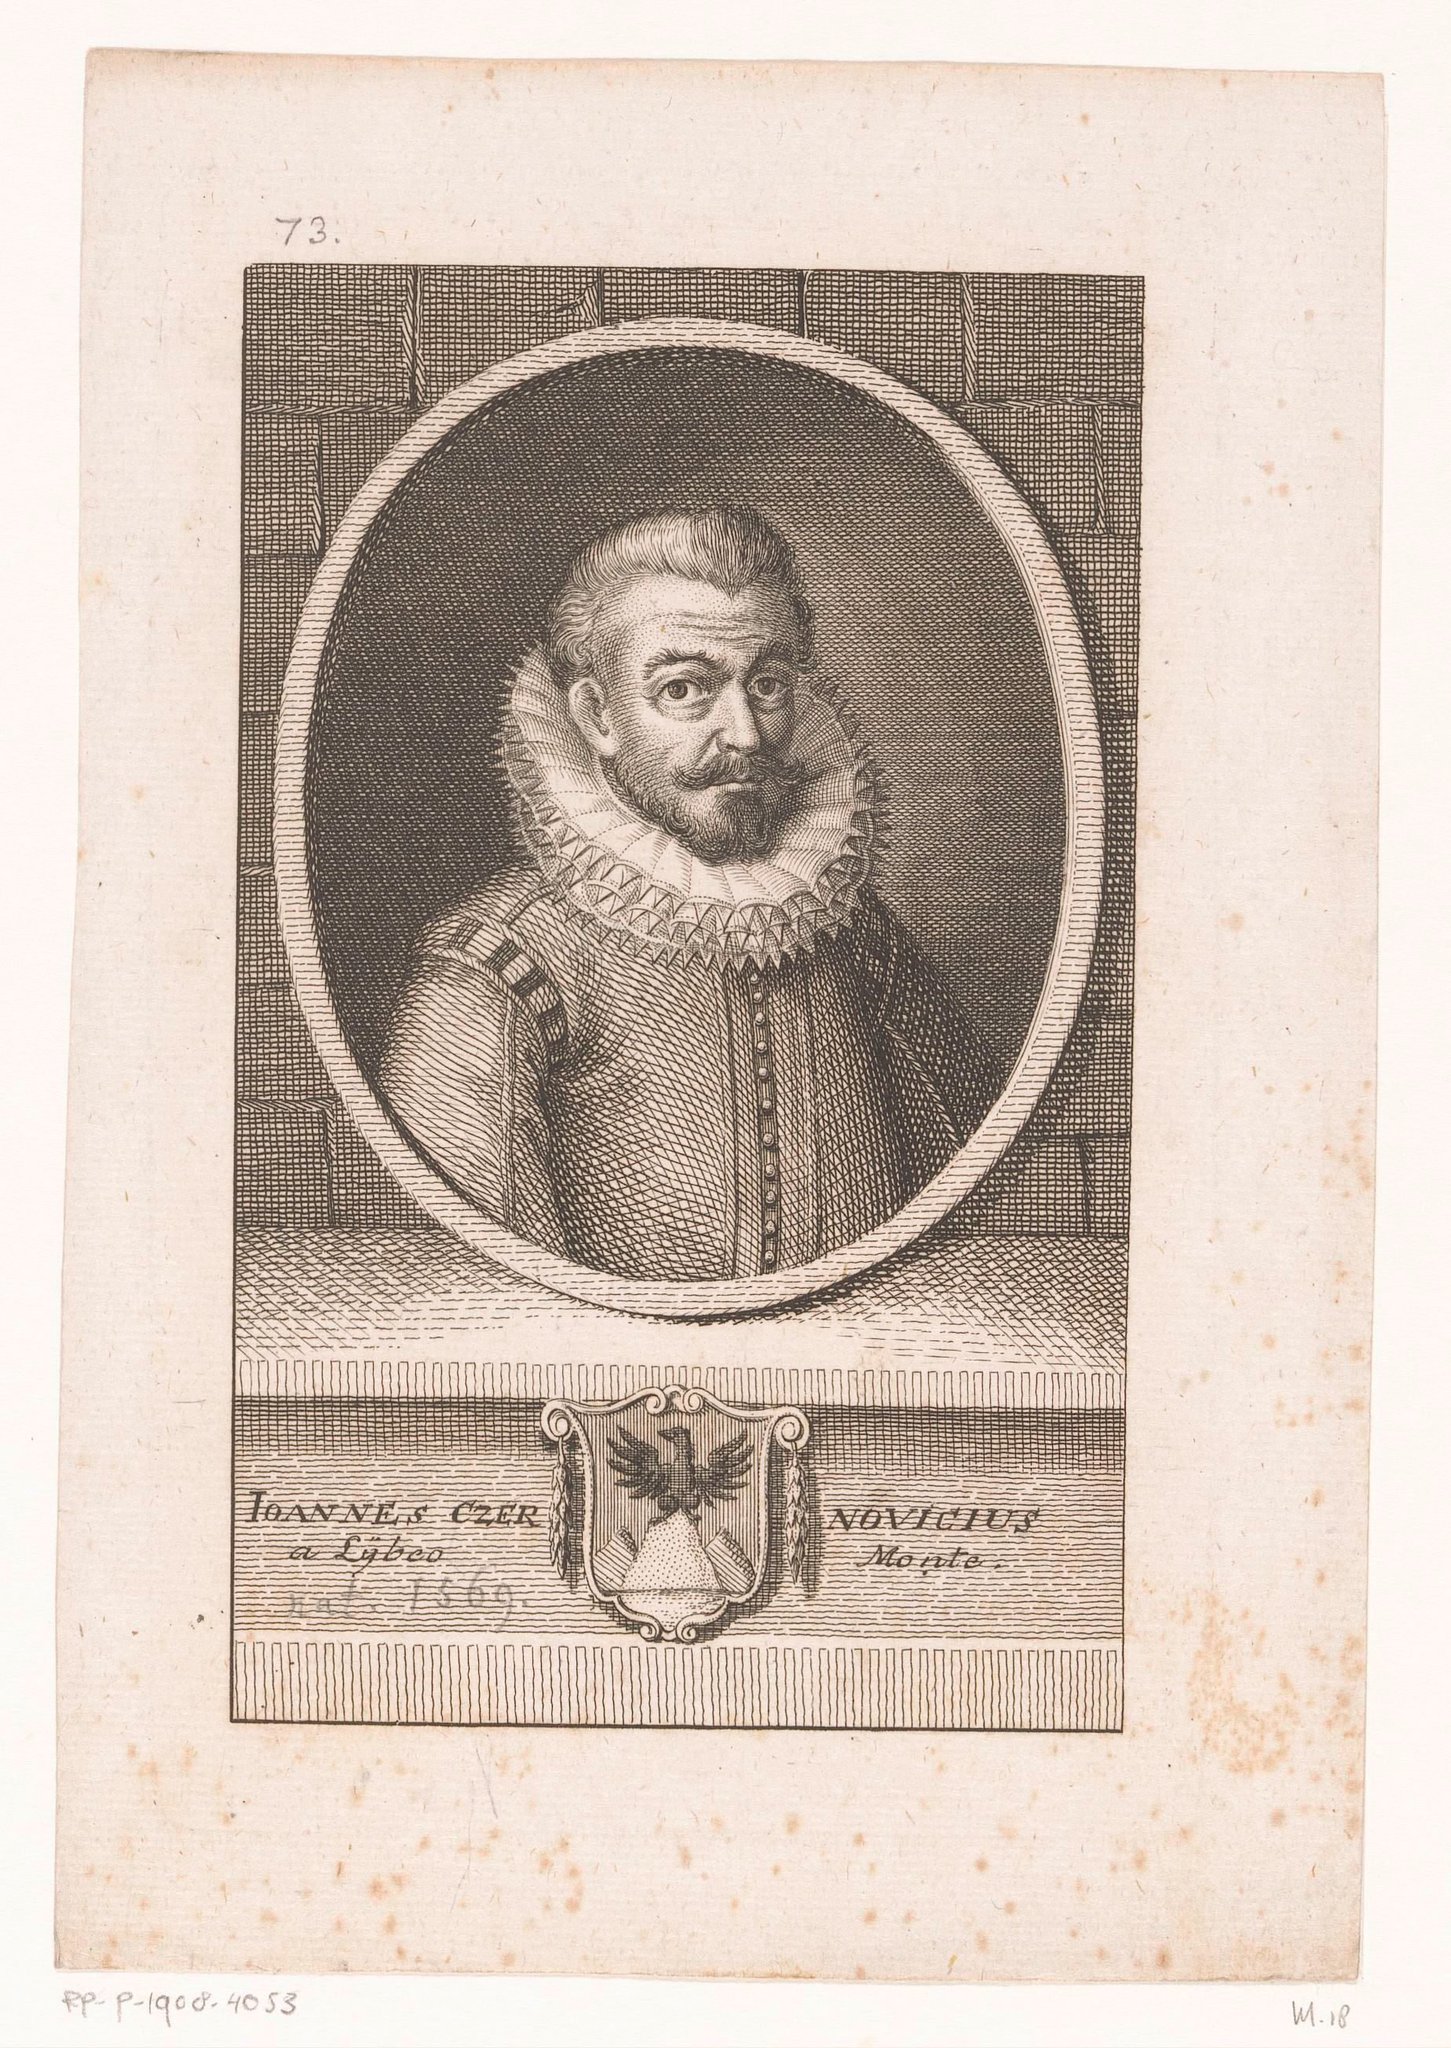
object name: print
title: Ioannes Czernovicius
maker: jan balzer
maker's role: print maker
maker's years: 1736-1799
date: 1746-1799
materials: paper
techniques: engraving, etching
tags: historical persons, writer, poet, author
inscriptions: collector's mark: Lugt 2228